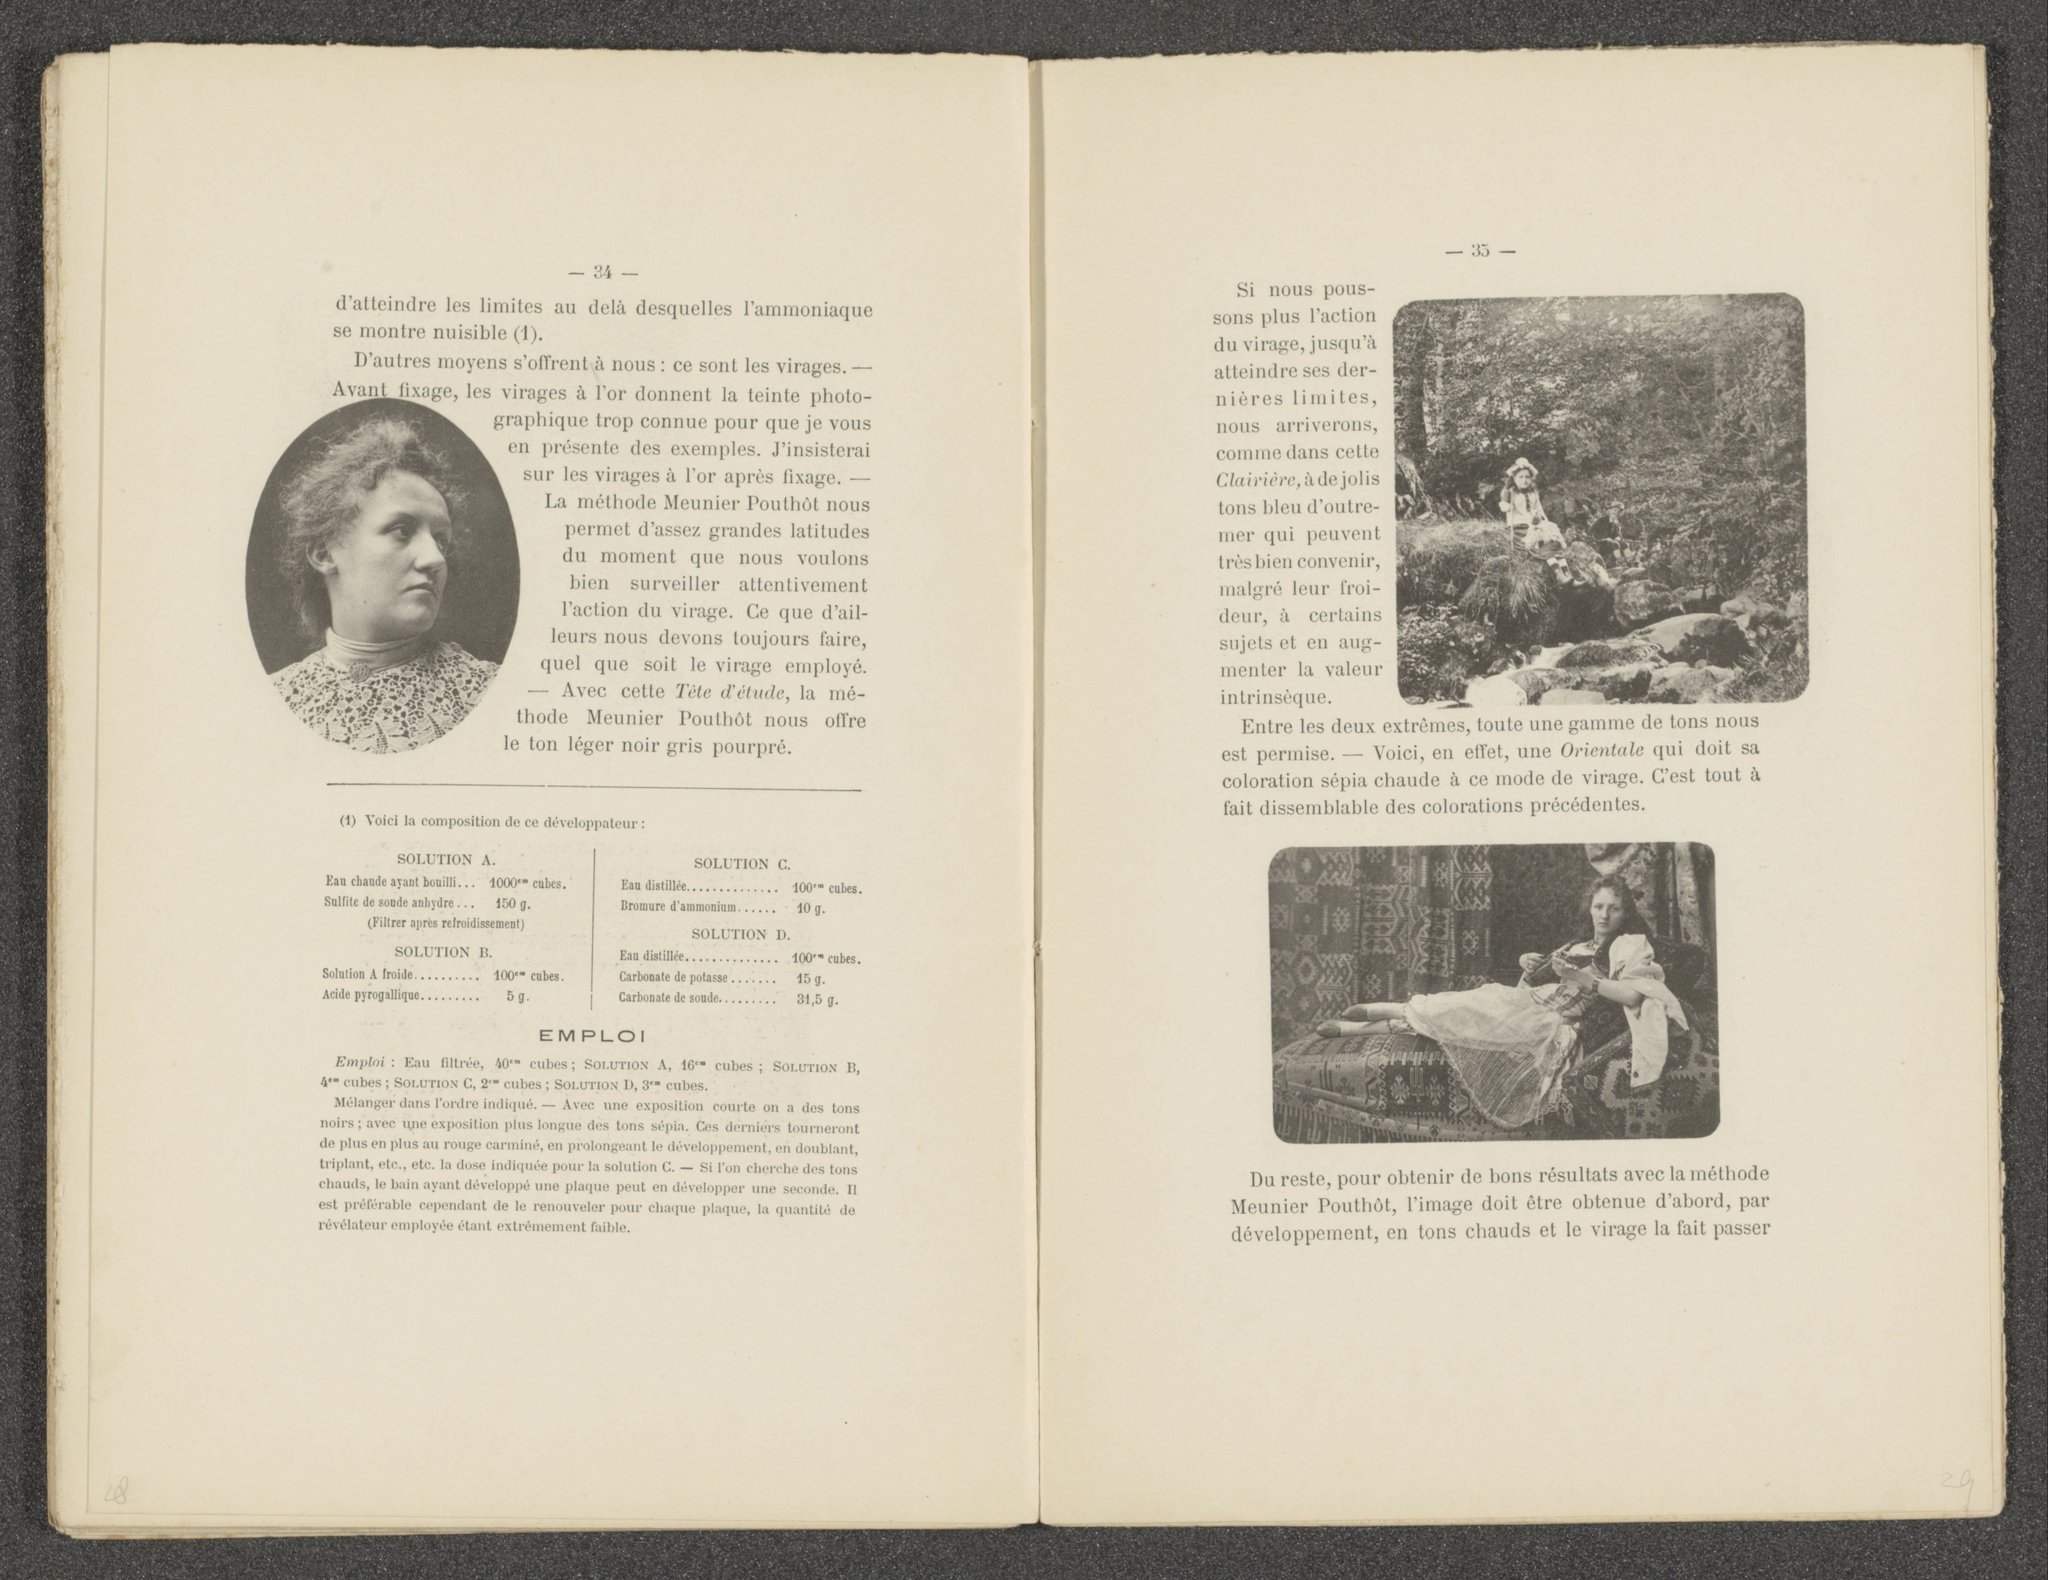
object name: page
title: Portret van een onbekende vrouw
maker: Anonymous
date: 1886-1896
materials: paper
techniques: photograph, printing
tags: anonymous historical person portrayed - bb - woman